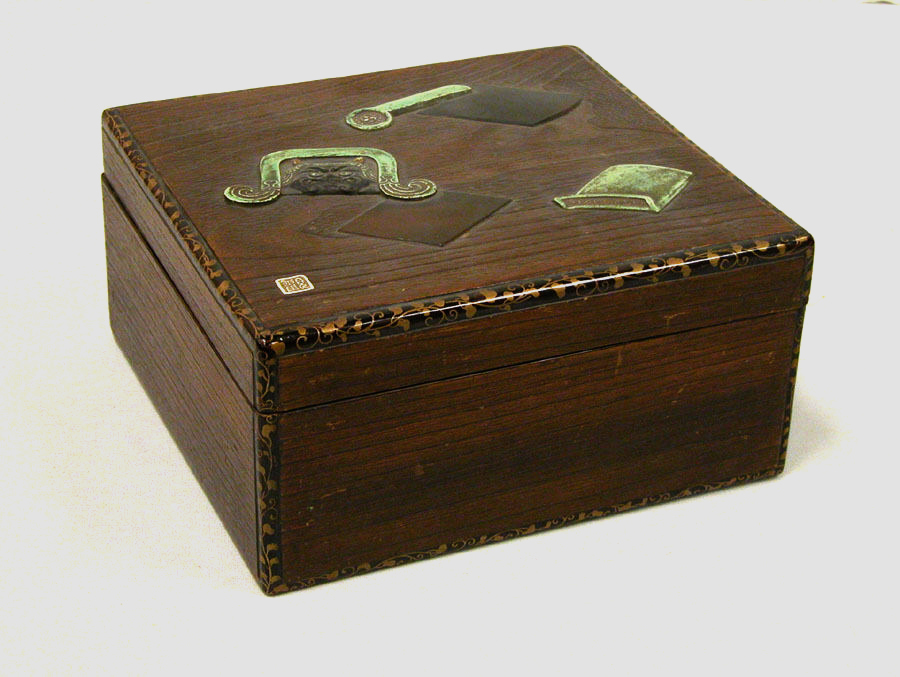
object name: box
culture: japanese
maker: ogawa haritsu (ritsuō)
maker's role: artist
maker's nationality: japanese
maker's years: 1663-1747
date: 1701-1800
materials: lacquer